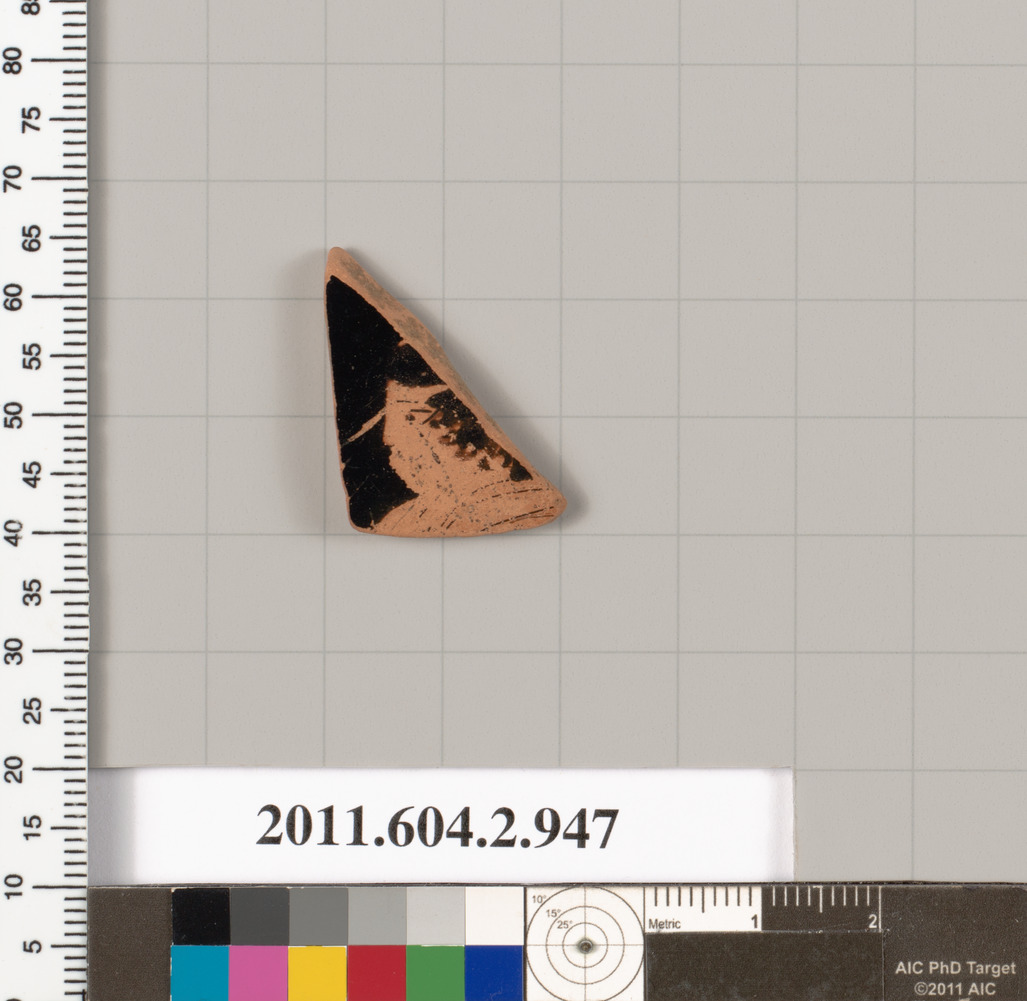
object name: oinochoe fragment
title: Terracotta fragment of an oinochoe (jug)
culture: greek, attic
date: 467-435 BCE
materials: terracotta